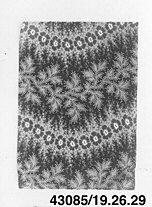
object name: sample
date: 1840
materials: cotton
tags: flowers,leaves